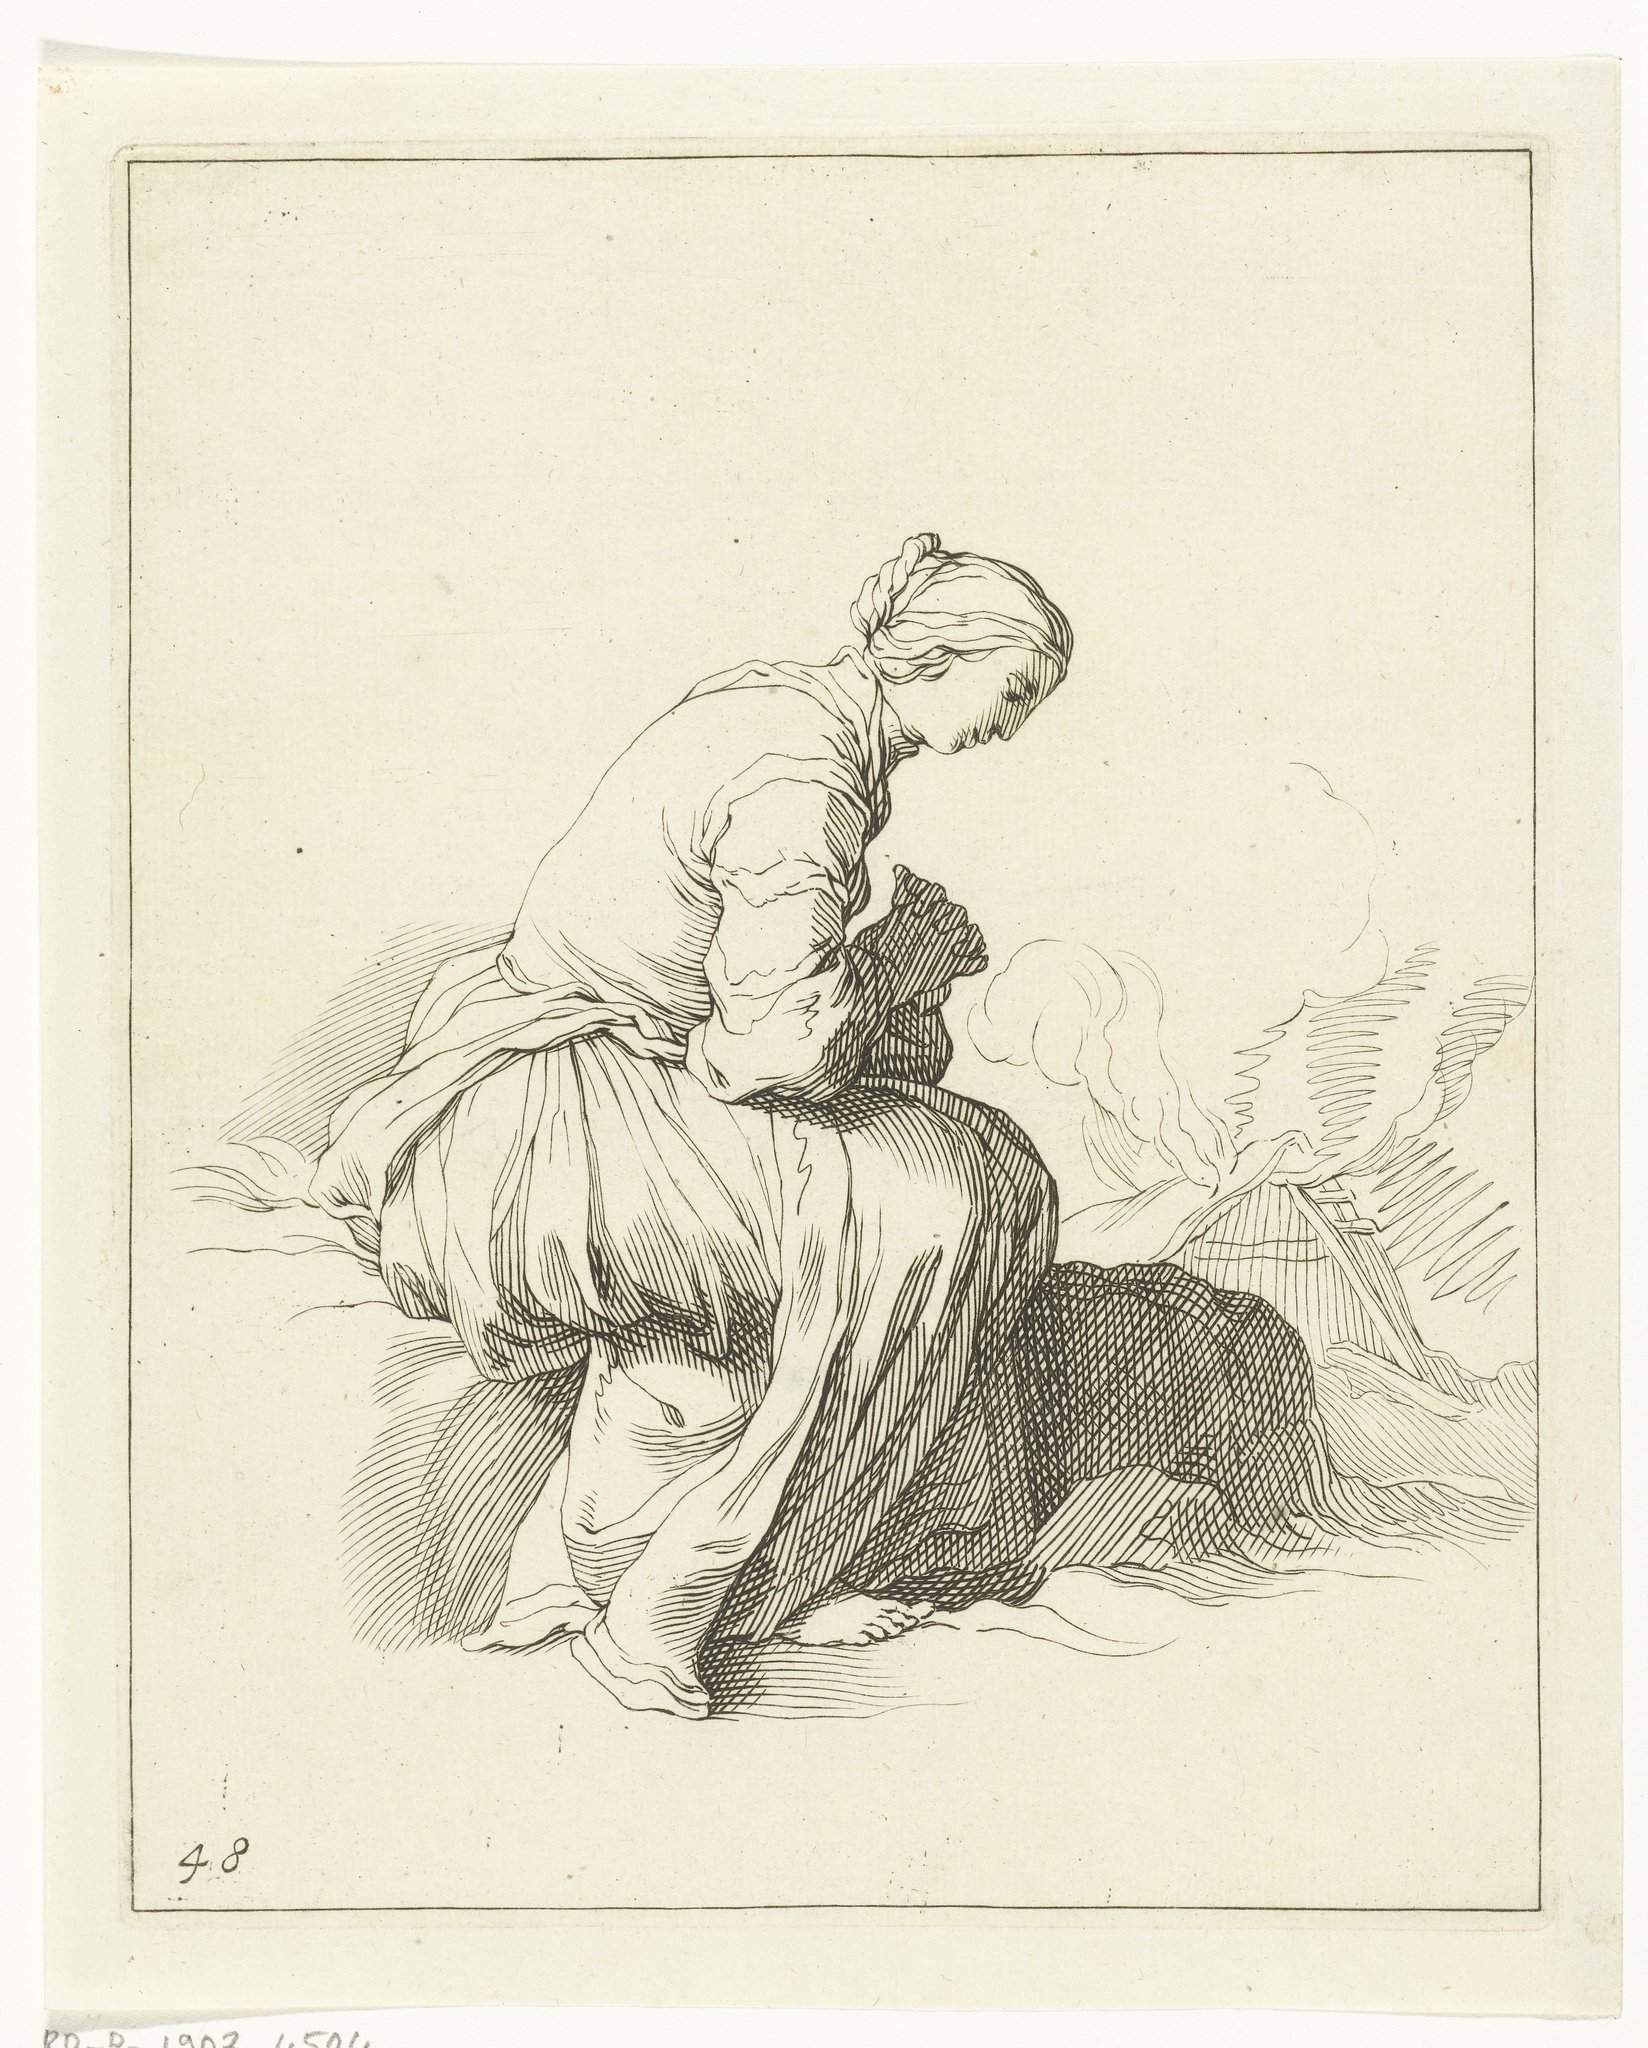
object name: print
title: Het tekenboek van Abraham Bloemaert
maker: frederick bloemaert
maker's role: print maker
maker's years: 1614-1669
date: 1679-1701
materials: paper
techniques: engraving, etching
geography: utrecht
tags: hands folded with fingers knit, (private) prayer; 'oratione', 'preghiere', 'preghiere a dio' (ripa)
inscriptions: collector's mark: Lugt 2228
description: Zittende vrouw met haar handen gevouwen in gebed. Op de achtergrond een brandend huis.